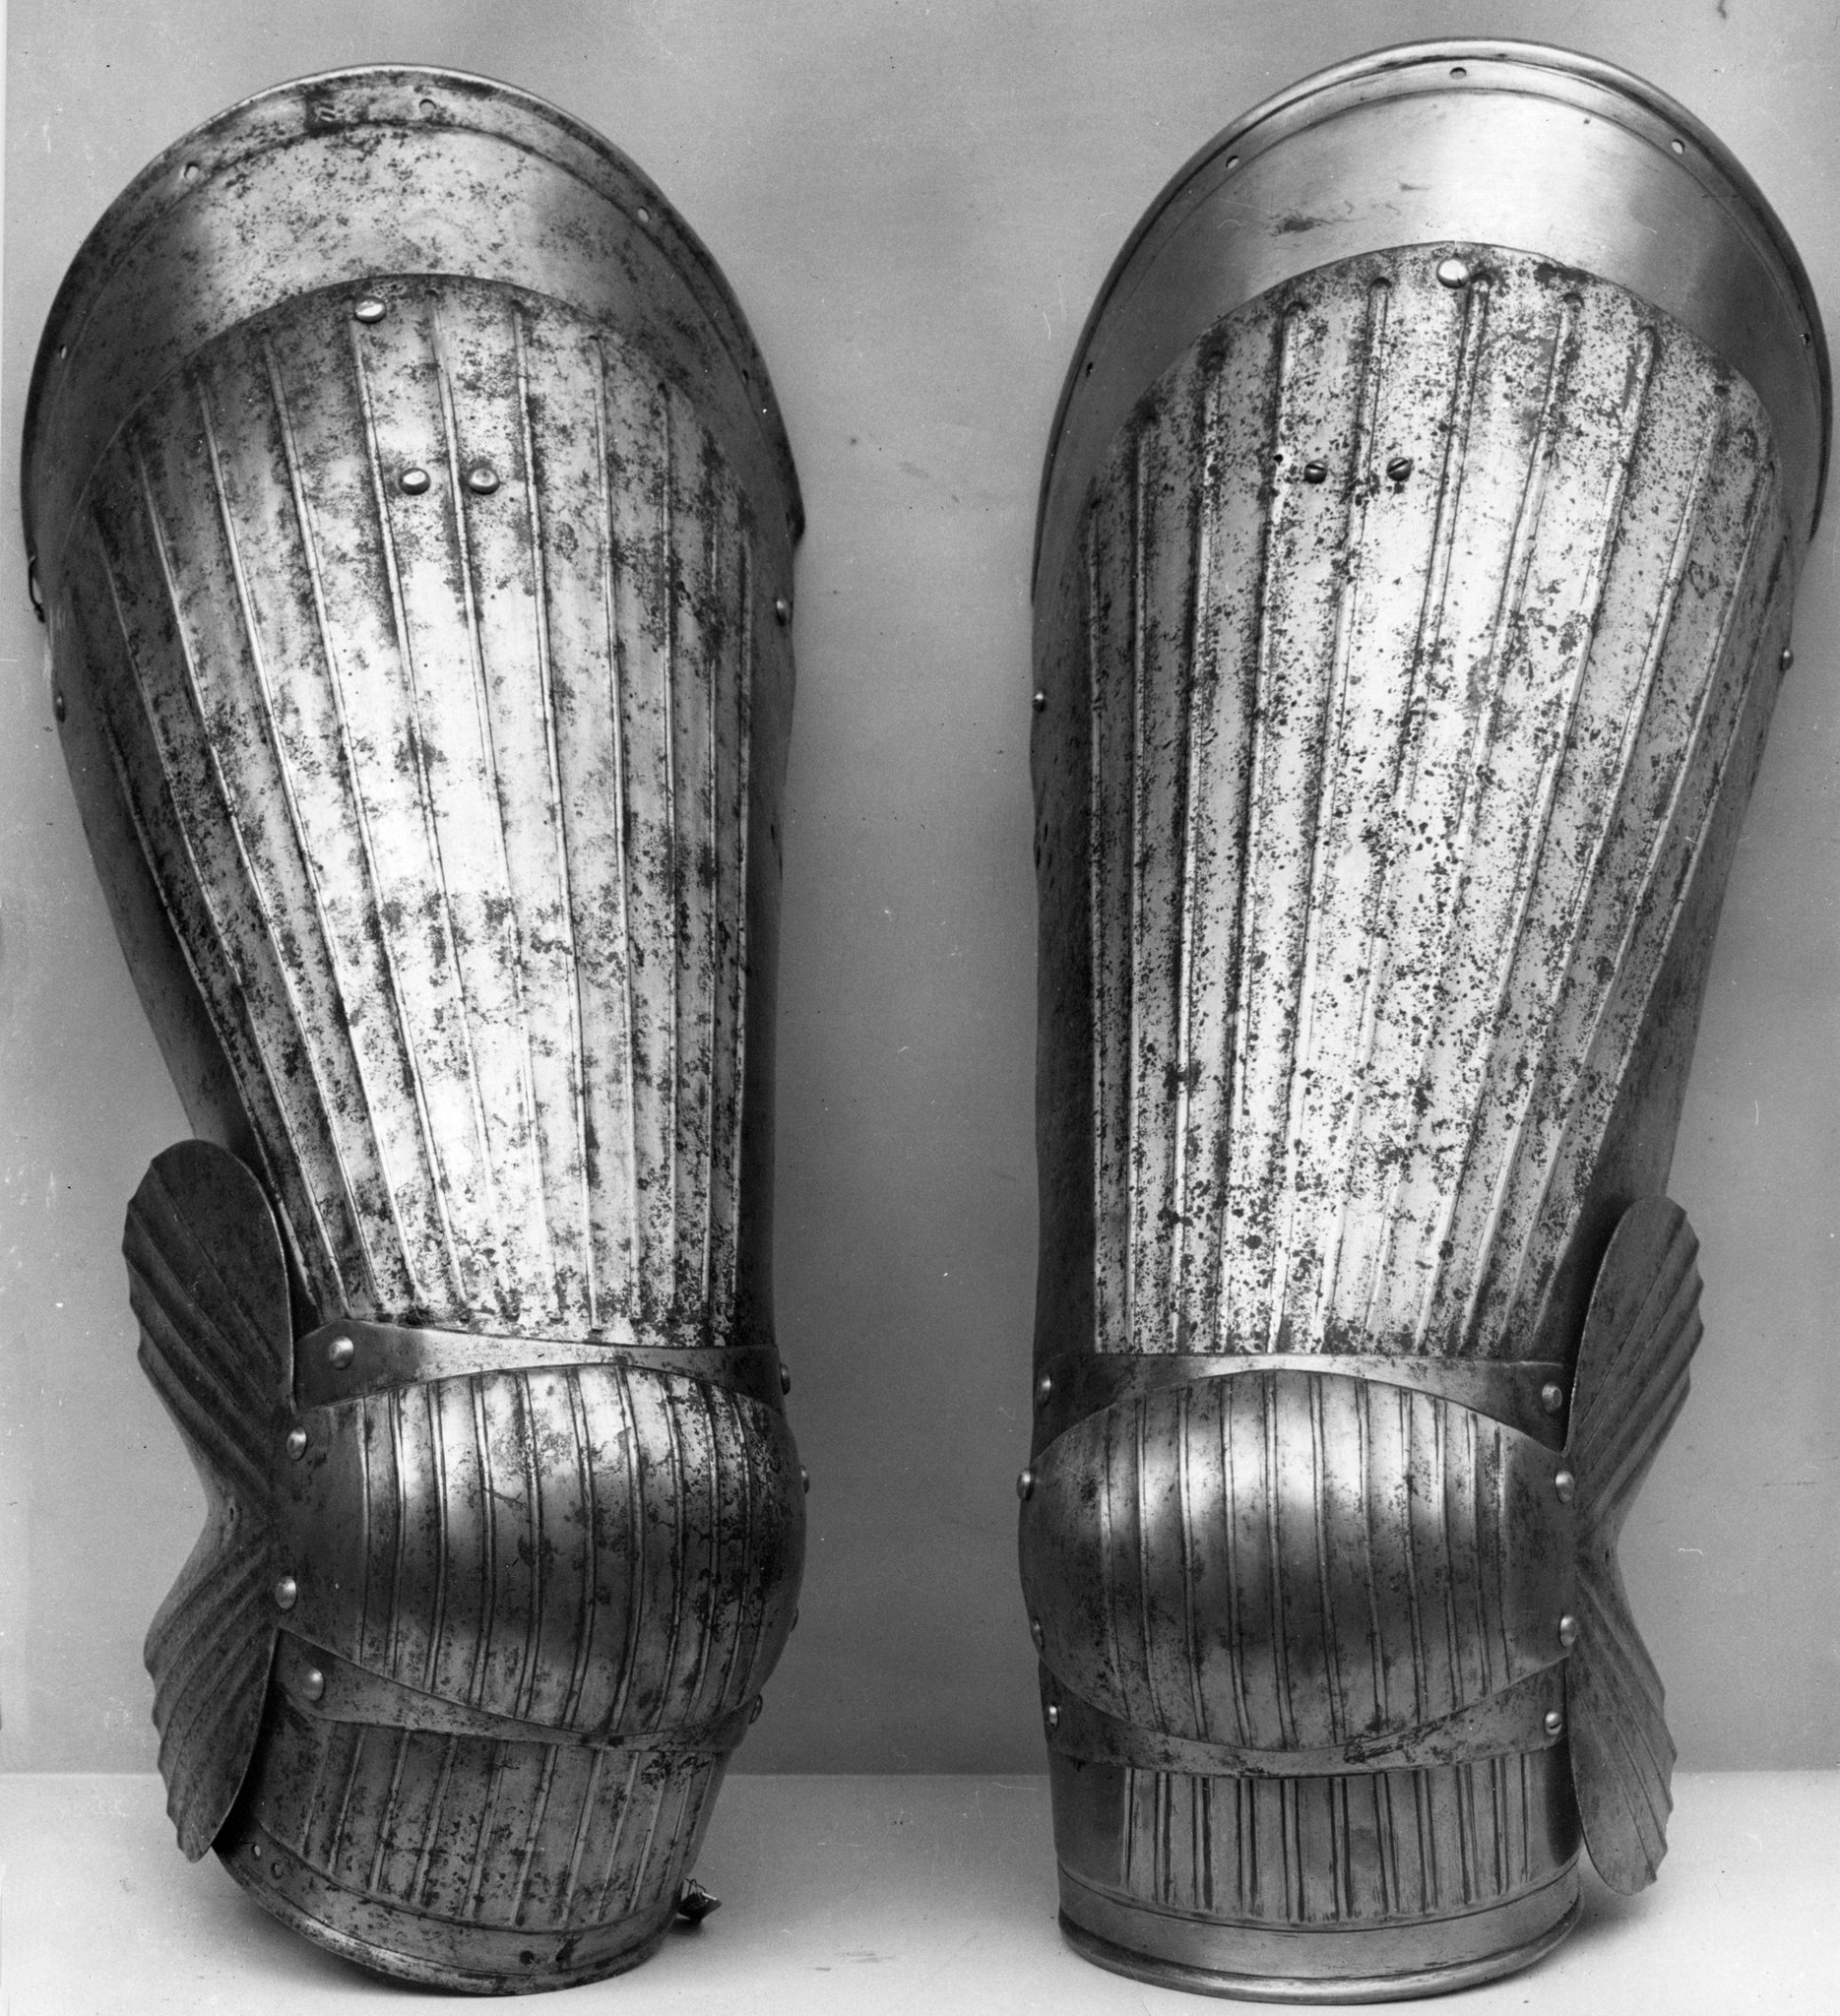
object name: pair of thigh and knee defense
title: Pair of Thigh and Knee Defenses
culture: german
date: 1501-1600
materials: steel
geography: germany